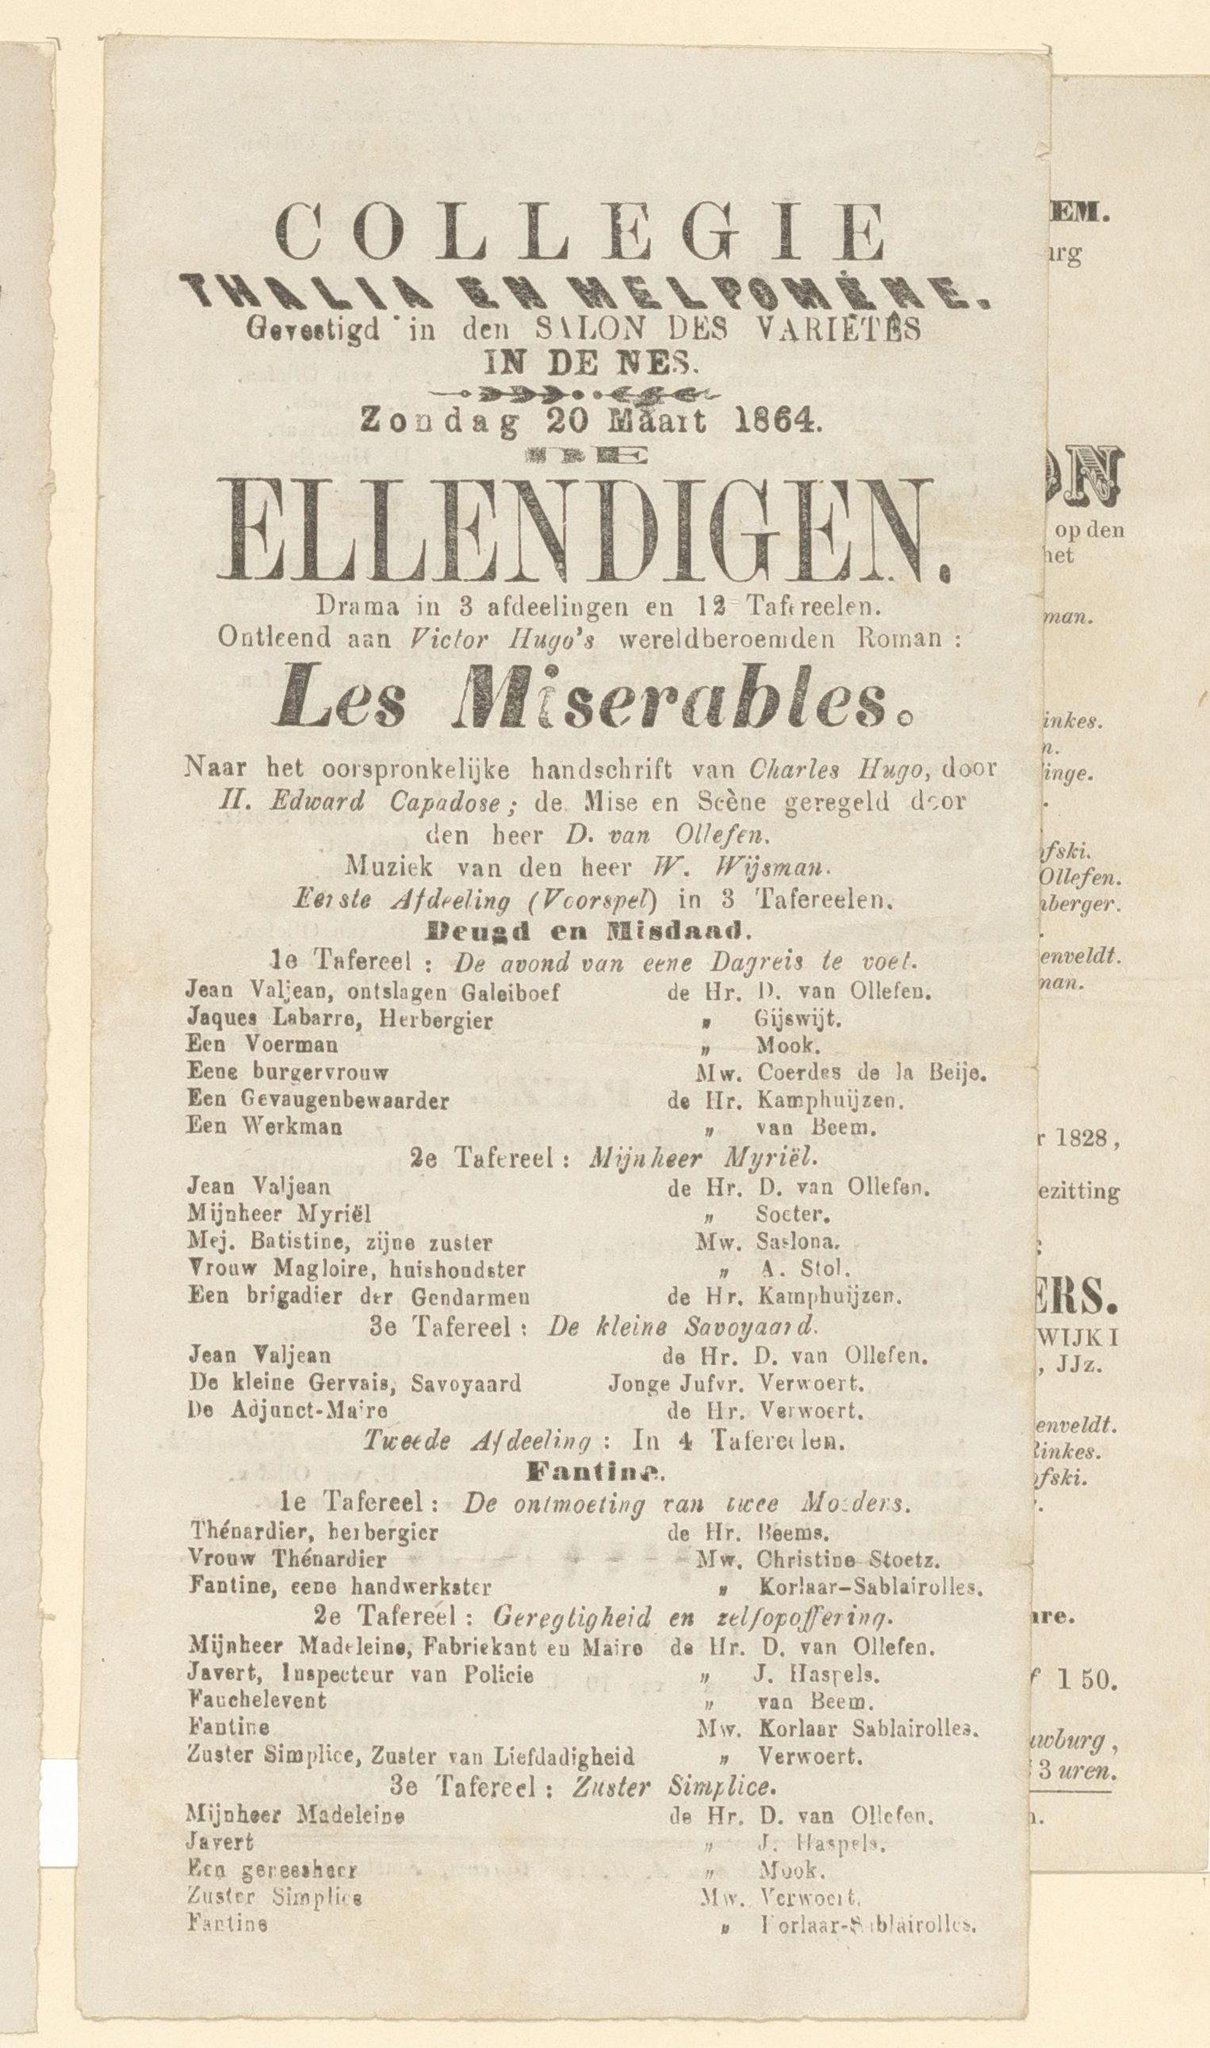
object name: text sheet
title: De Ellendigen / Les Miserables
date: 1864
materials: paper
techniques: letterpress printing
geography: amsterdam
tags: theatre, theatrical performance, art, amsterdam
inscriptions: collector's mark: Lugt 1641, stamp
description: Aankondiging van de voorstelling De Ellendigen, naar Les Miserables van Victor Hugo. Onderwerpsrubrieken binnen de Atlas Zeden en Gewoonten: Tooneel, Toneelprogramma’s.